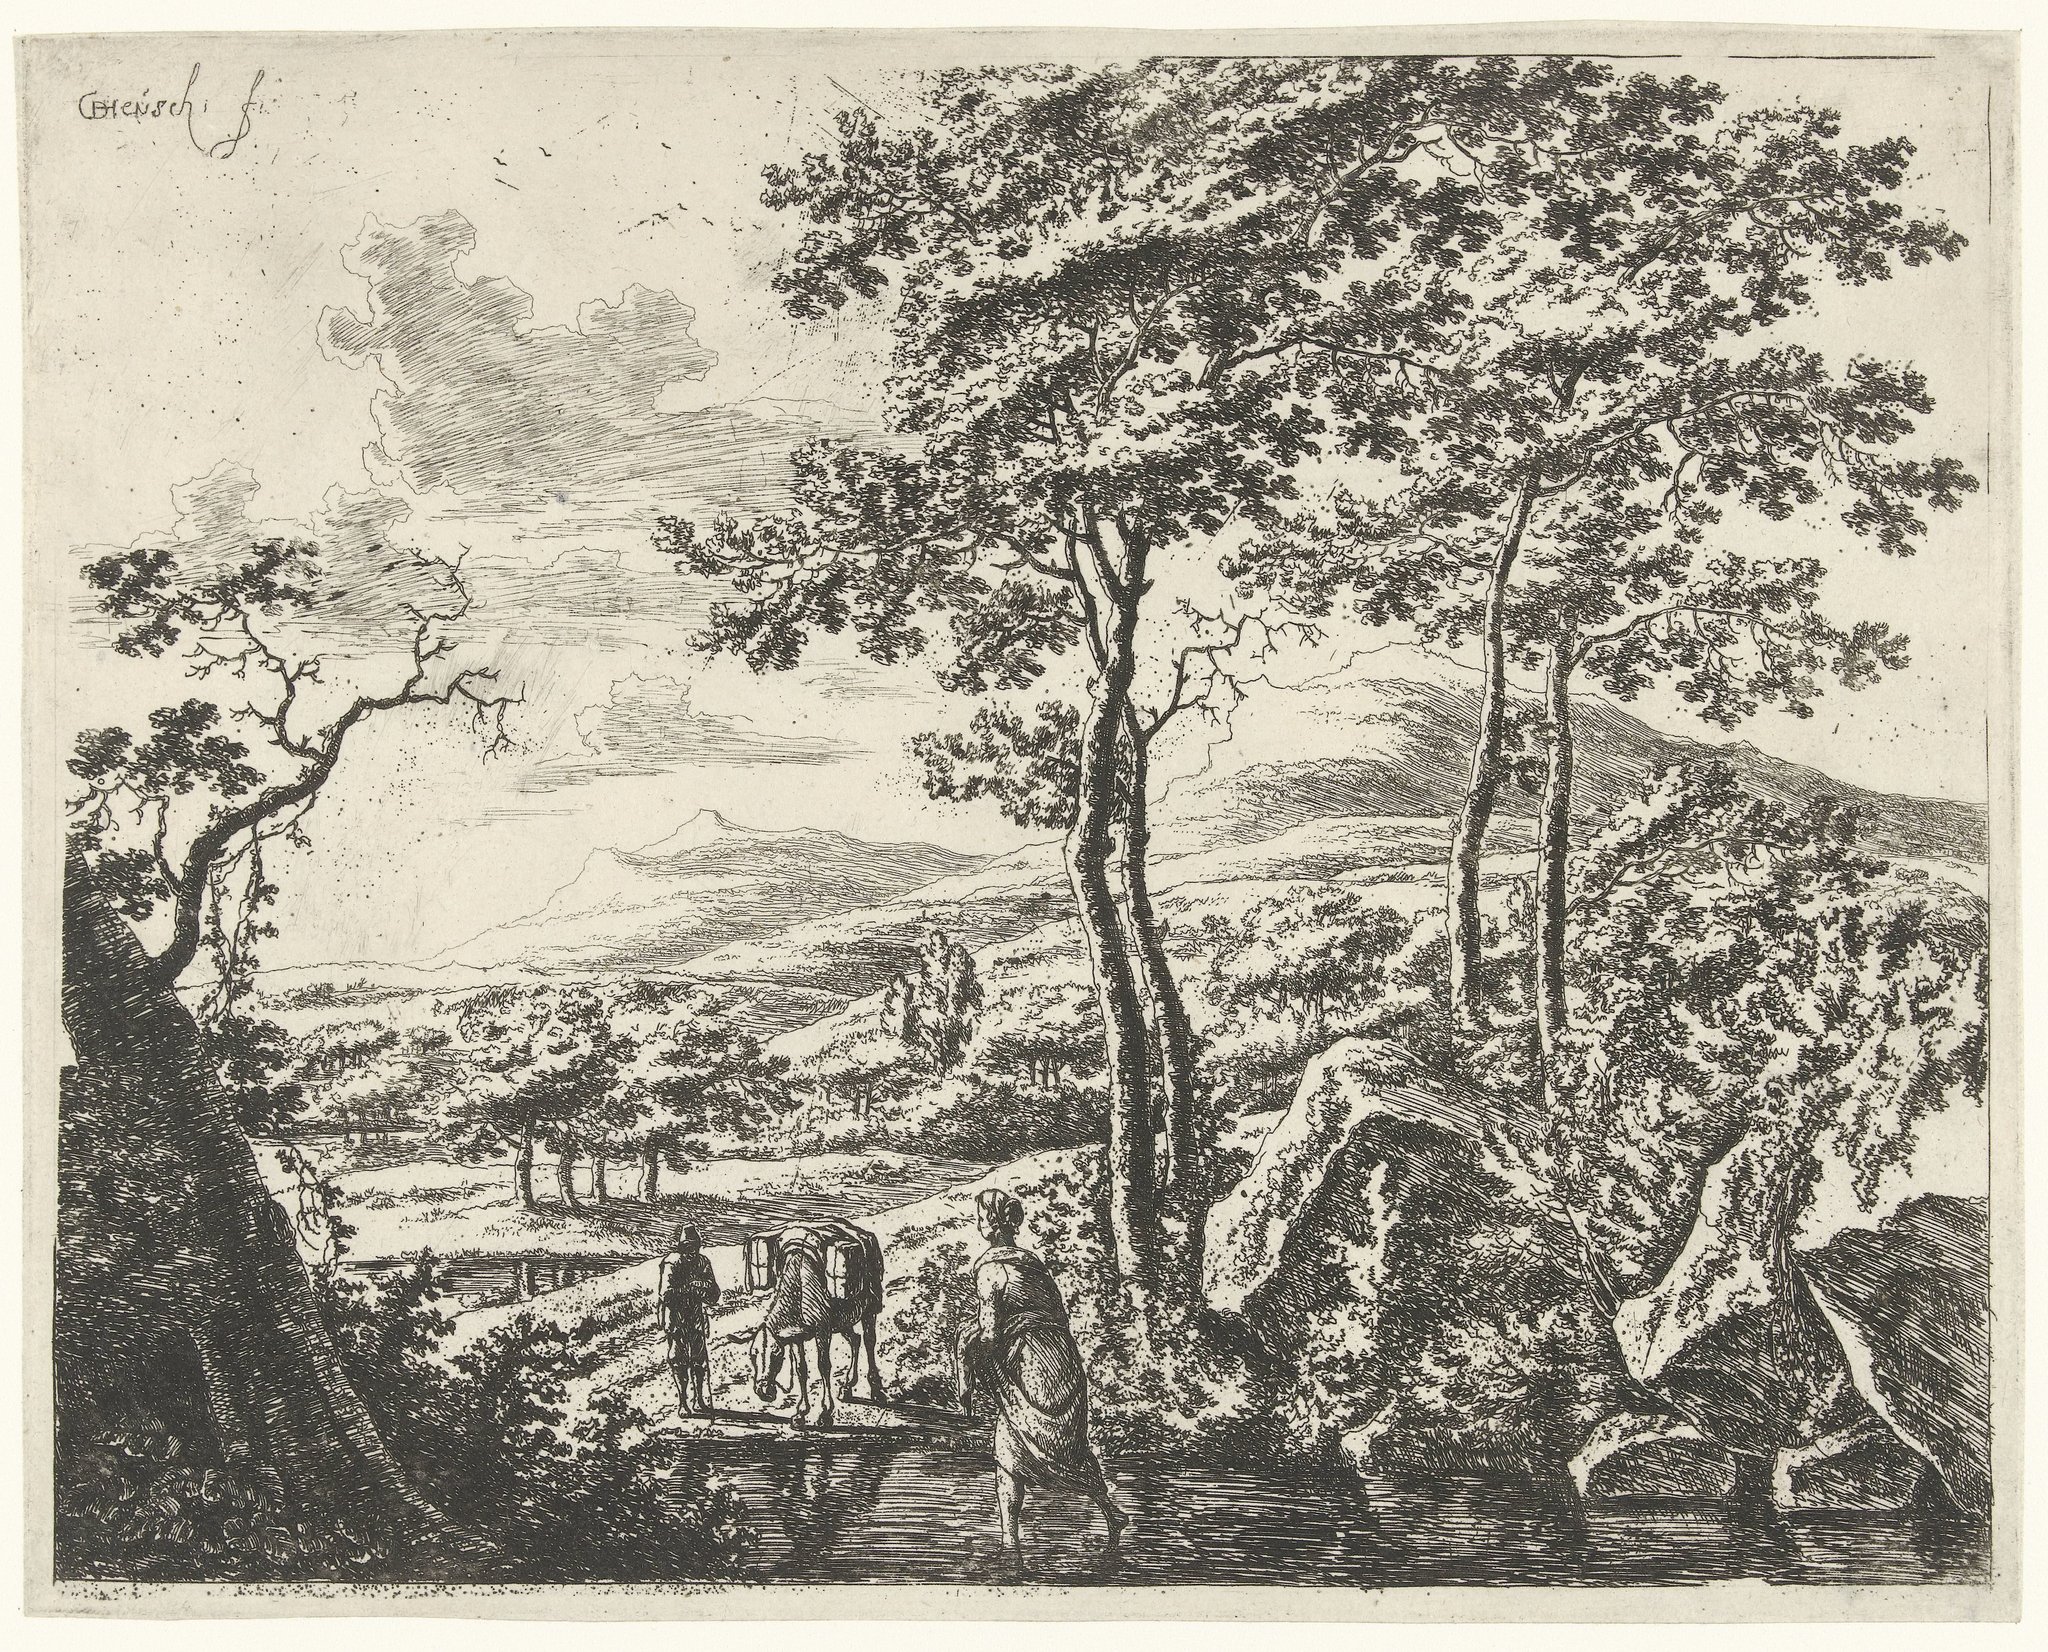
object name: print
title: Landschap met een muilezeldrijver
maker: willem de heusch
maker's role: draughtsman, painter, print maker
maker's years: 1625-1692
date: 1690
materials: paper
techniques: etching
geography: utrecht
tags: pack-animal, landscapes with waters, waterscapes, seascapes (in the temperate zone), mule, wading, paddling - aa - female human figure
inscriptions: collector's mark: Lugt 240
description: Een berglandschap met een man met een pakezel. Hij leunt op zijn staf aan de oever van een beek, waardoor een vrouw waadt.